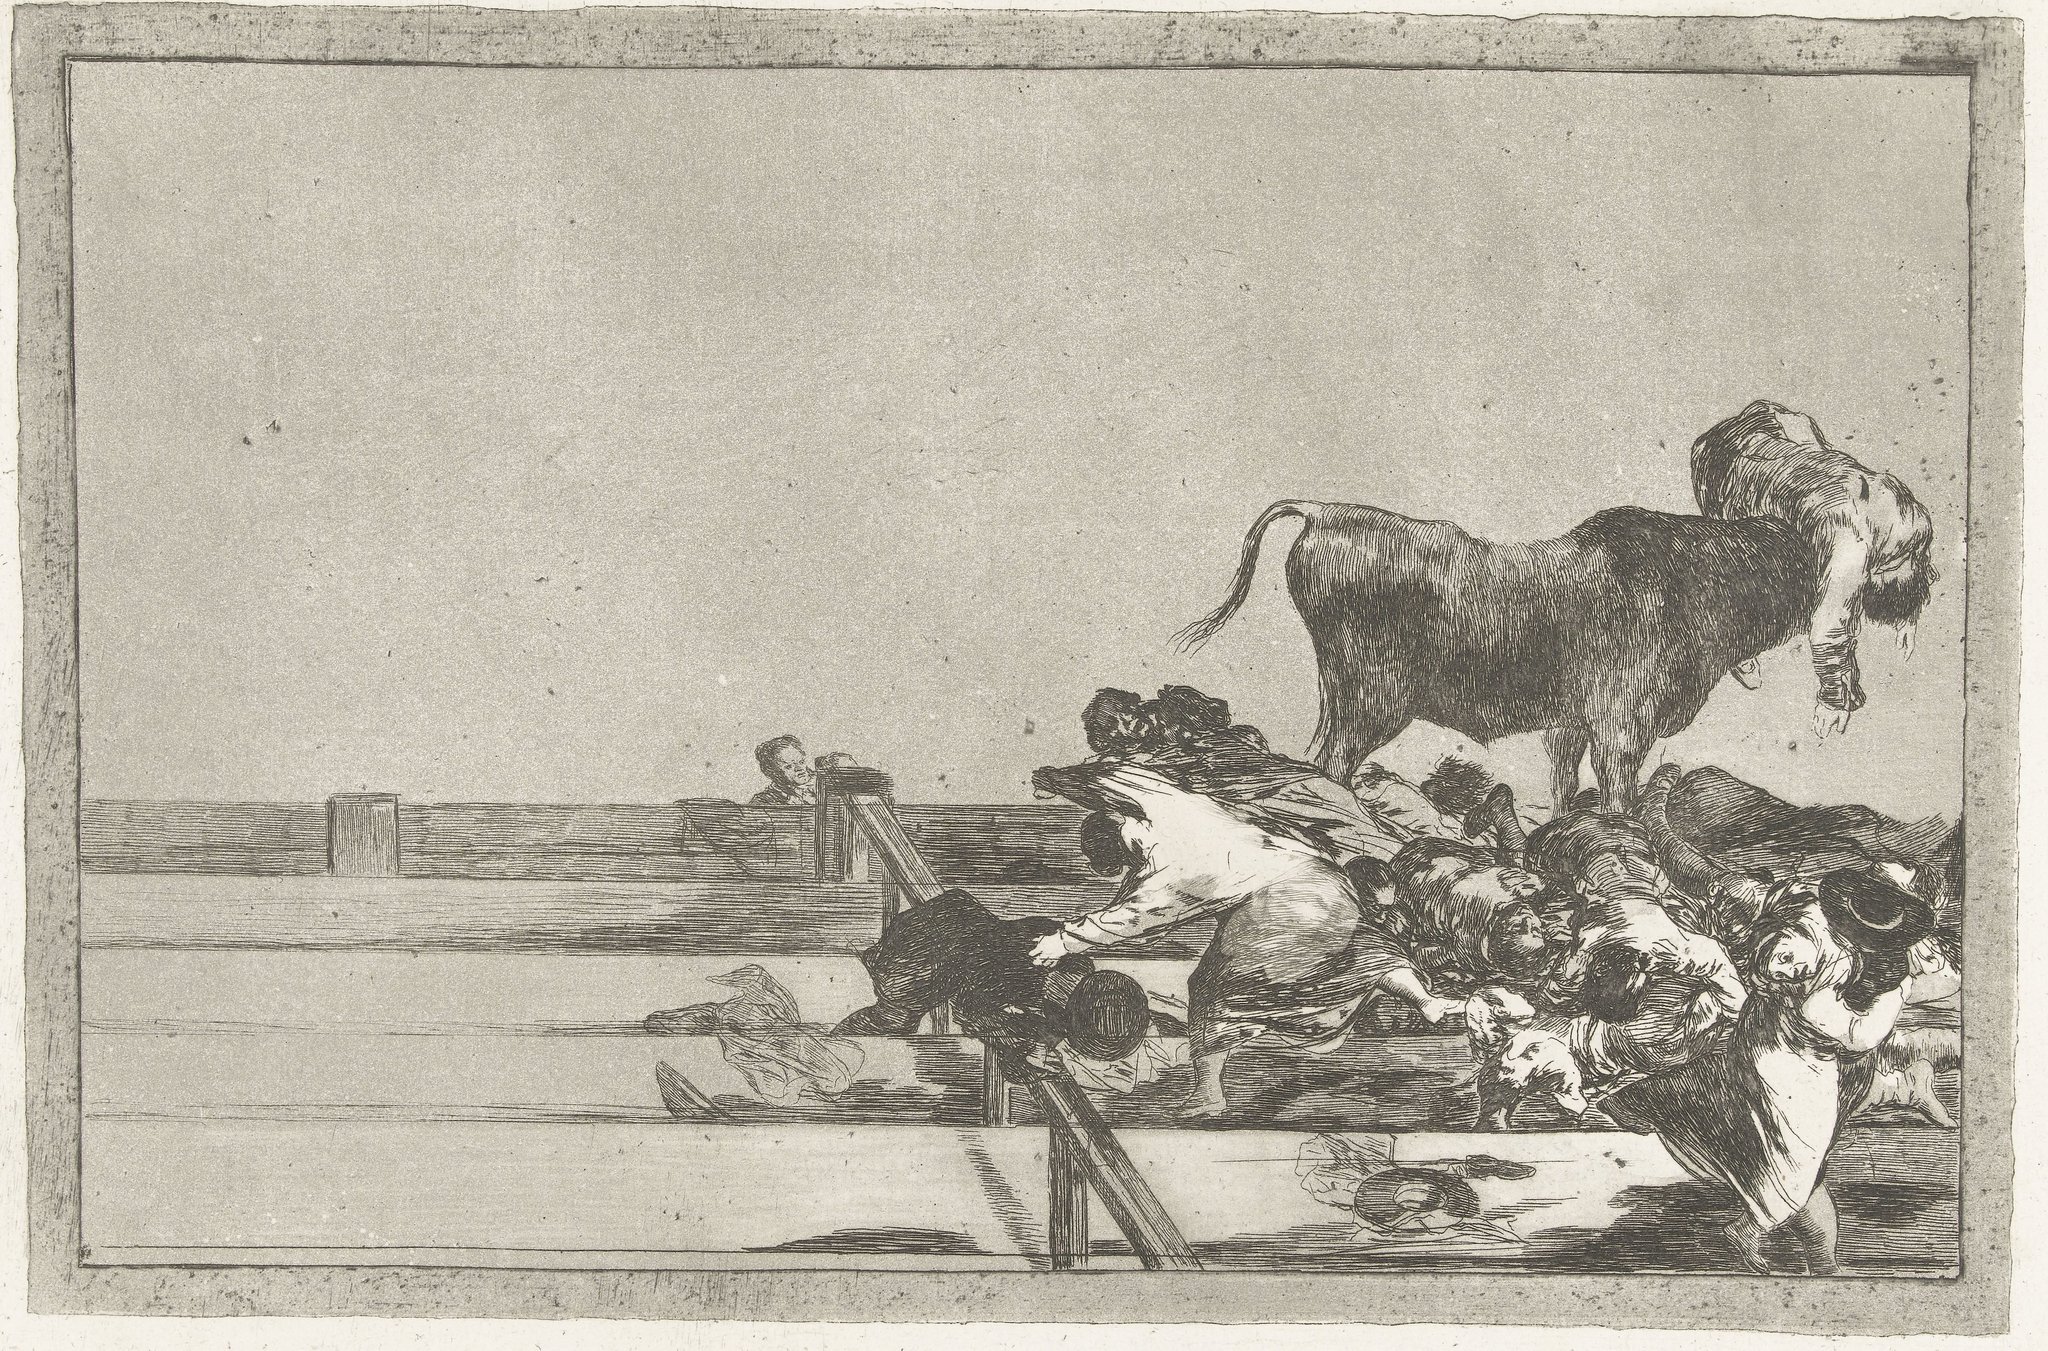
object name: print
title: Desgracias acaecidas en el tendido de la plaza de Madrid, y muerte del alcalde de Torrejon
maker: francisco de goya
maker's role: draughtsman, painter, print maker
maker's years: 1746-1828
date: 1811-1816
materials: paper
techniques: aquatint, drypoint, etching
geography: spain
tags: bullfight, violent death, being killed; being mishandled and maltreated; seeking death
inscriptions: collector's mark: Lugt 805b, collector's mark: Lugt 2228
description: De eerste vijf rijen van de tribune in de arena van Madrid. De stier, staand op de tribune, heeft de burgemeester van Torrejon aan zijn hoorns gespietst. Een groep mensen probeert in paniek weg te vluchten.